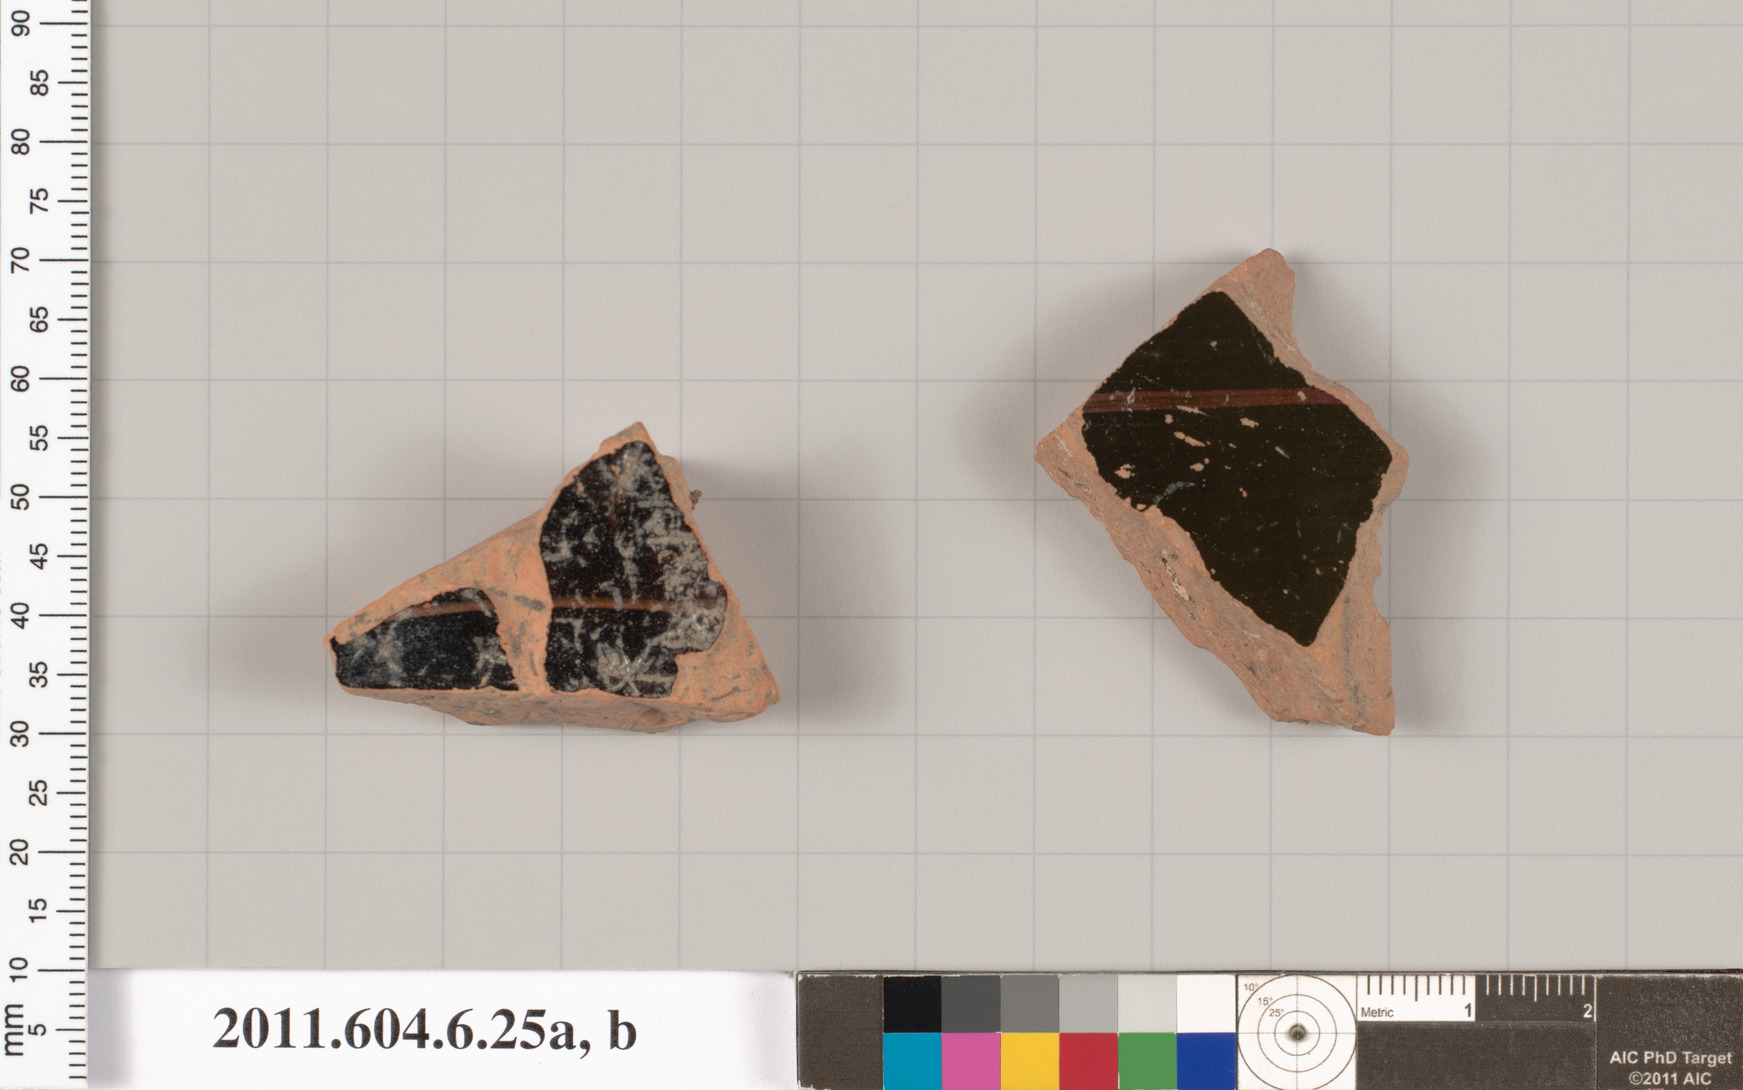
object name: undetermined shape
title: Terracotta fragments of undetermined shapes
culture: greek, attic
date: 600-401 BCE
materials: terracotta